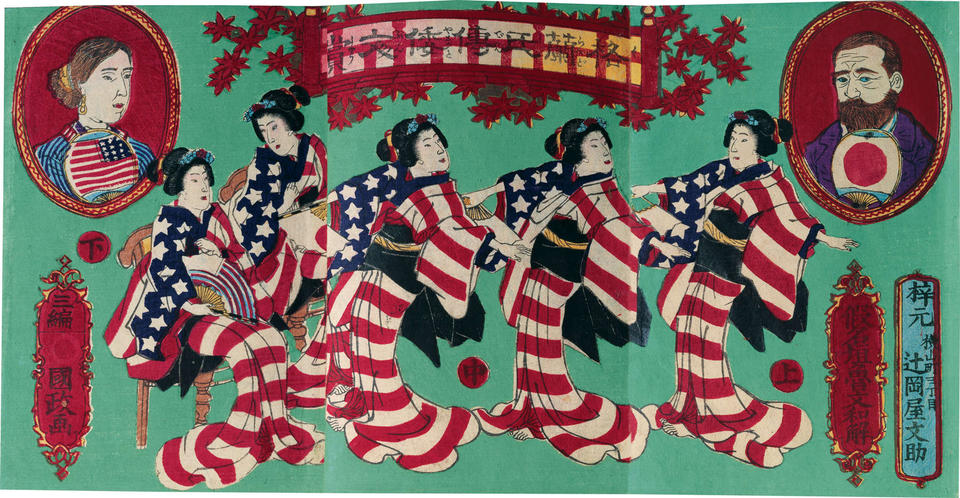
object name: illustrated book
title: The Life of President Grant in Japanese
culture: japanese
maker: utagawa kunisada iii (kunimasa iv)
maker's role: artist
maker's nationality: japanese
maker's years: 1848-1920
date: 1879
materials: ink, paper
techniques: woodblock print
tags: men,portraits,women,flags